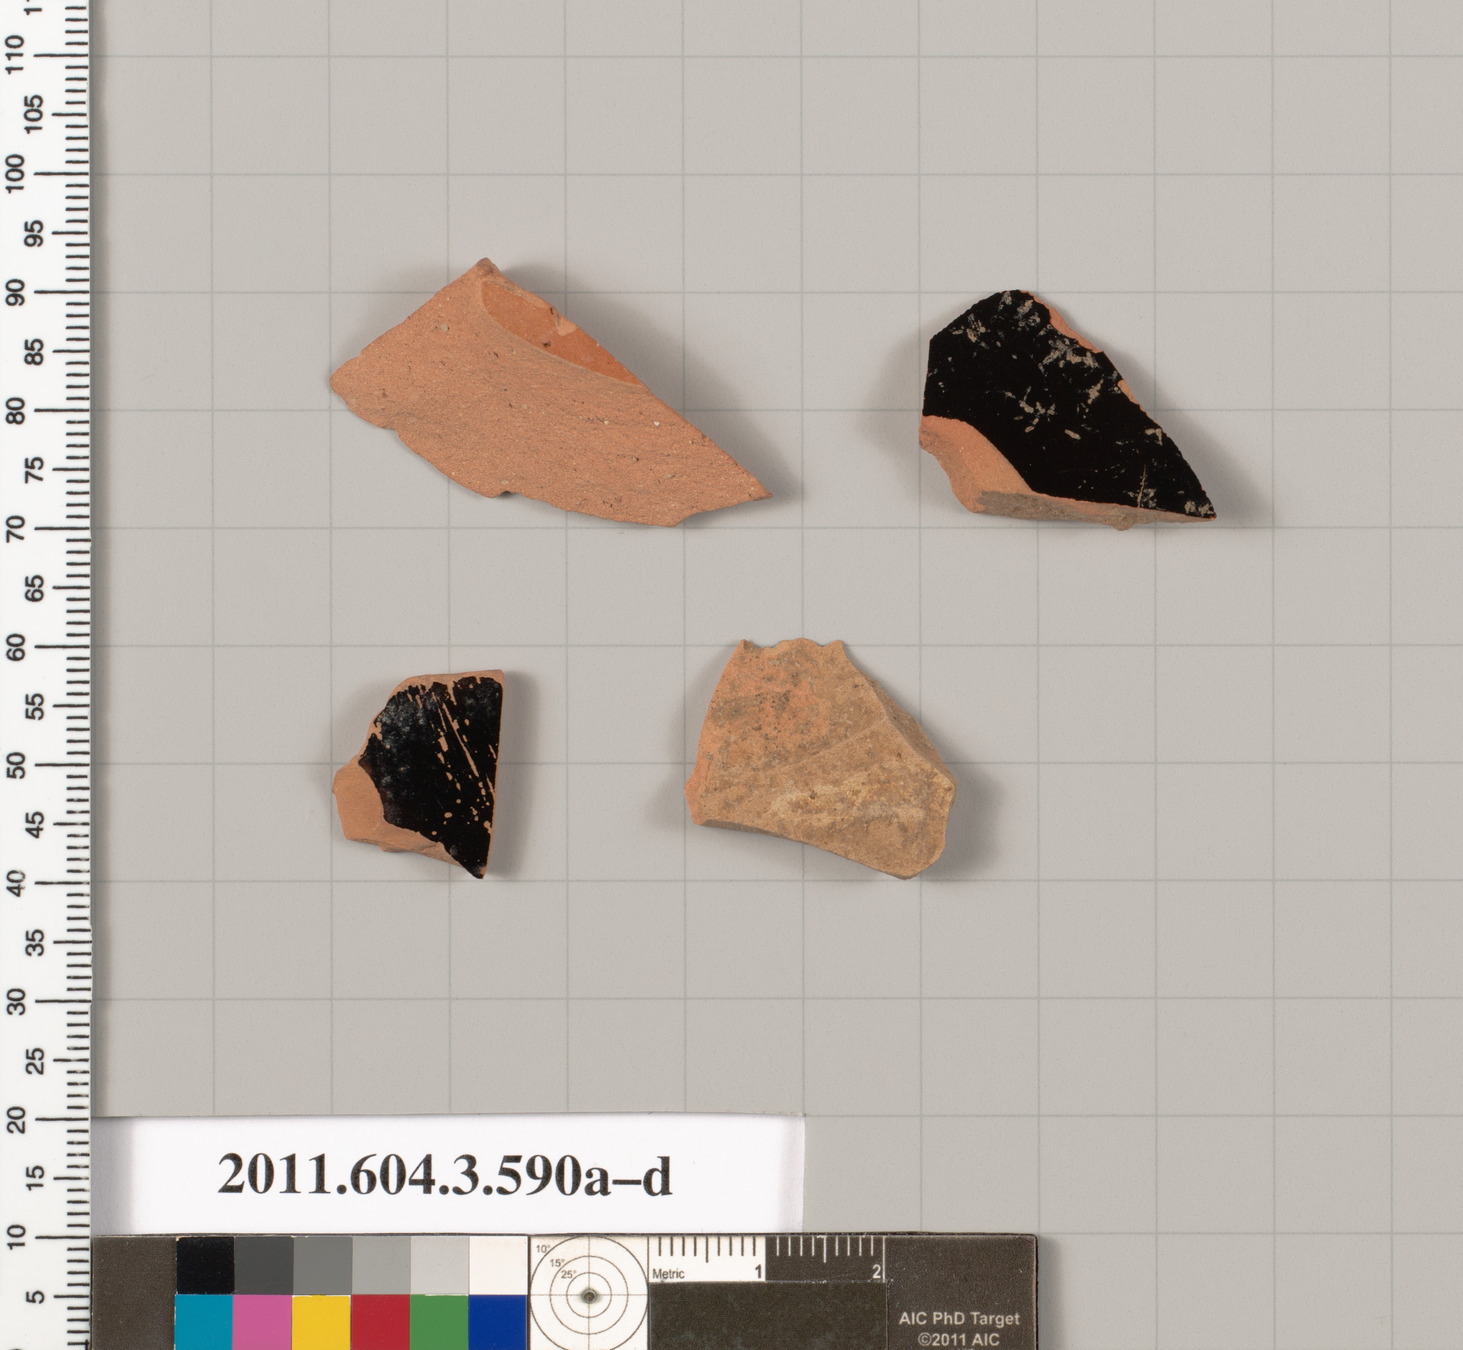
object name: calyx krater or column krater fragment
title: Terracotta fragments of column-kraters (bowls for mixing wine and water) or calyx-kraters (bowls for mixing wine and water)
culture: greek, attic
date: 600-401 BCE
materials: terracotta